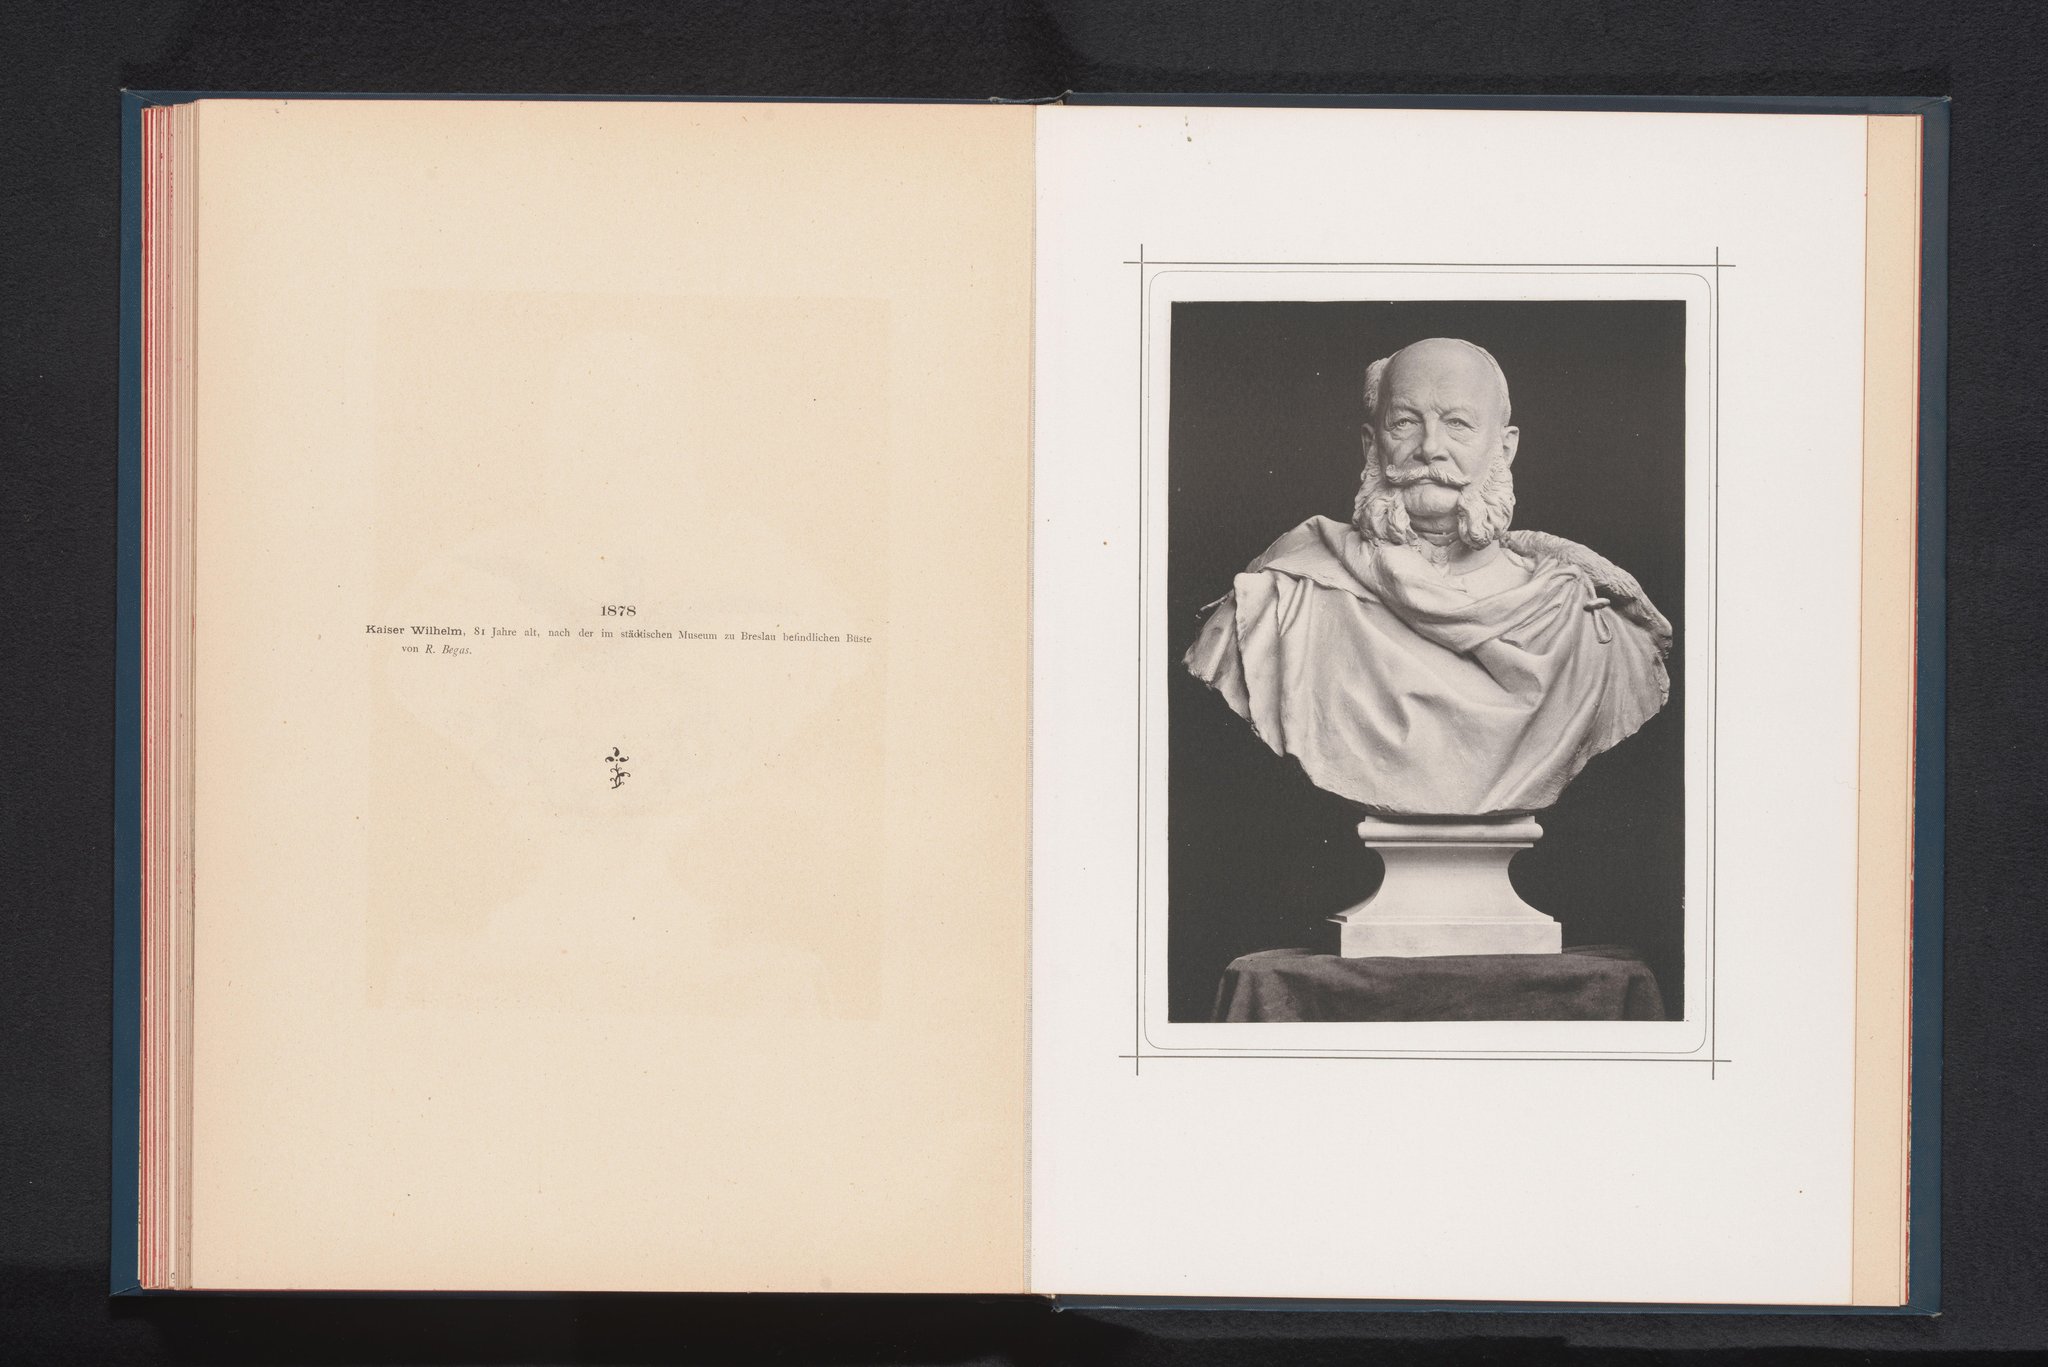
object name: photomechanical print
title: Buste van Wilhelm I op een leeftijd van 81 jaar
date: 1887-1897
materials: paper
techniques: photograph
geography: germany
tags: wilhelm i (keizer van duitsland), chest, bust, ruler, sovereign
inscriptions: inscription: ‘1878 Kaiser Wilhelm, 81 Jahre alt, nach der im städtischen Museum zu Breslau befindlichen Büste von R. Begas.’